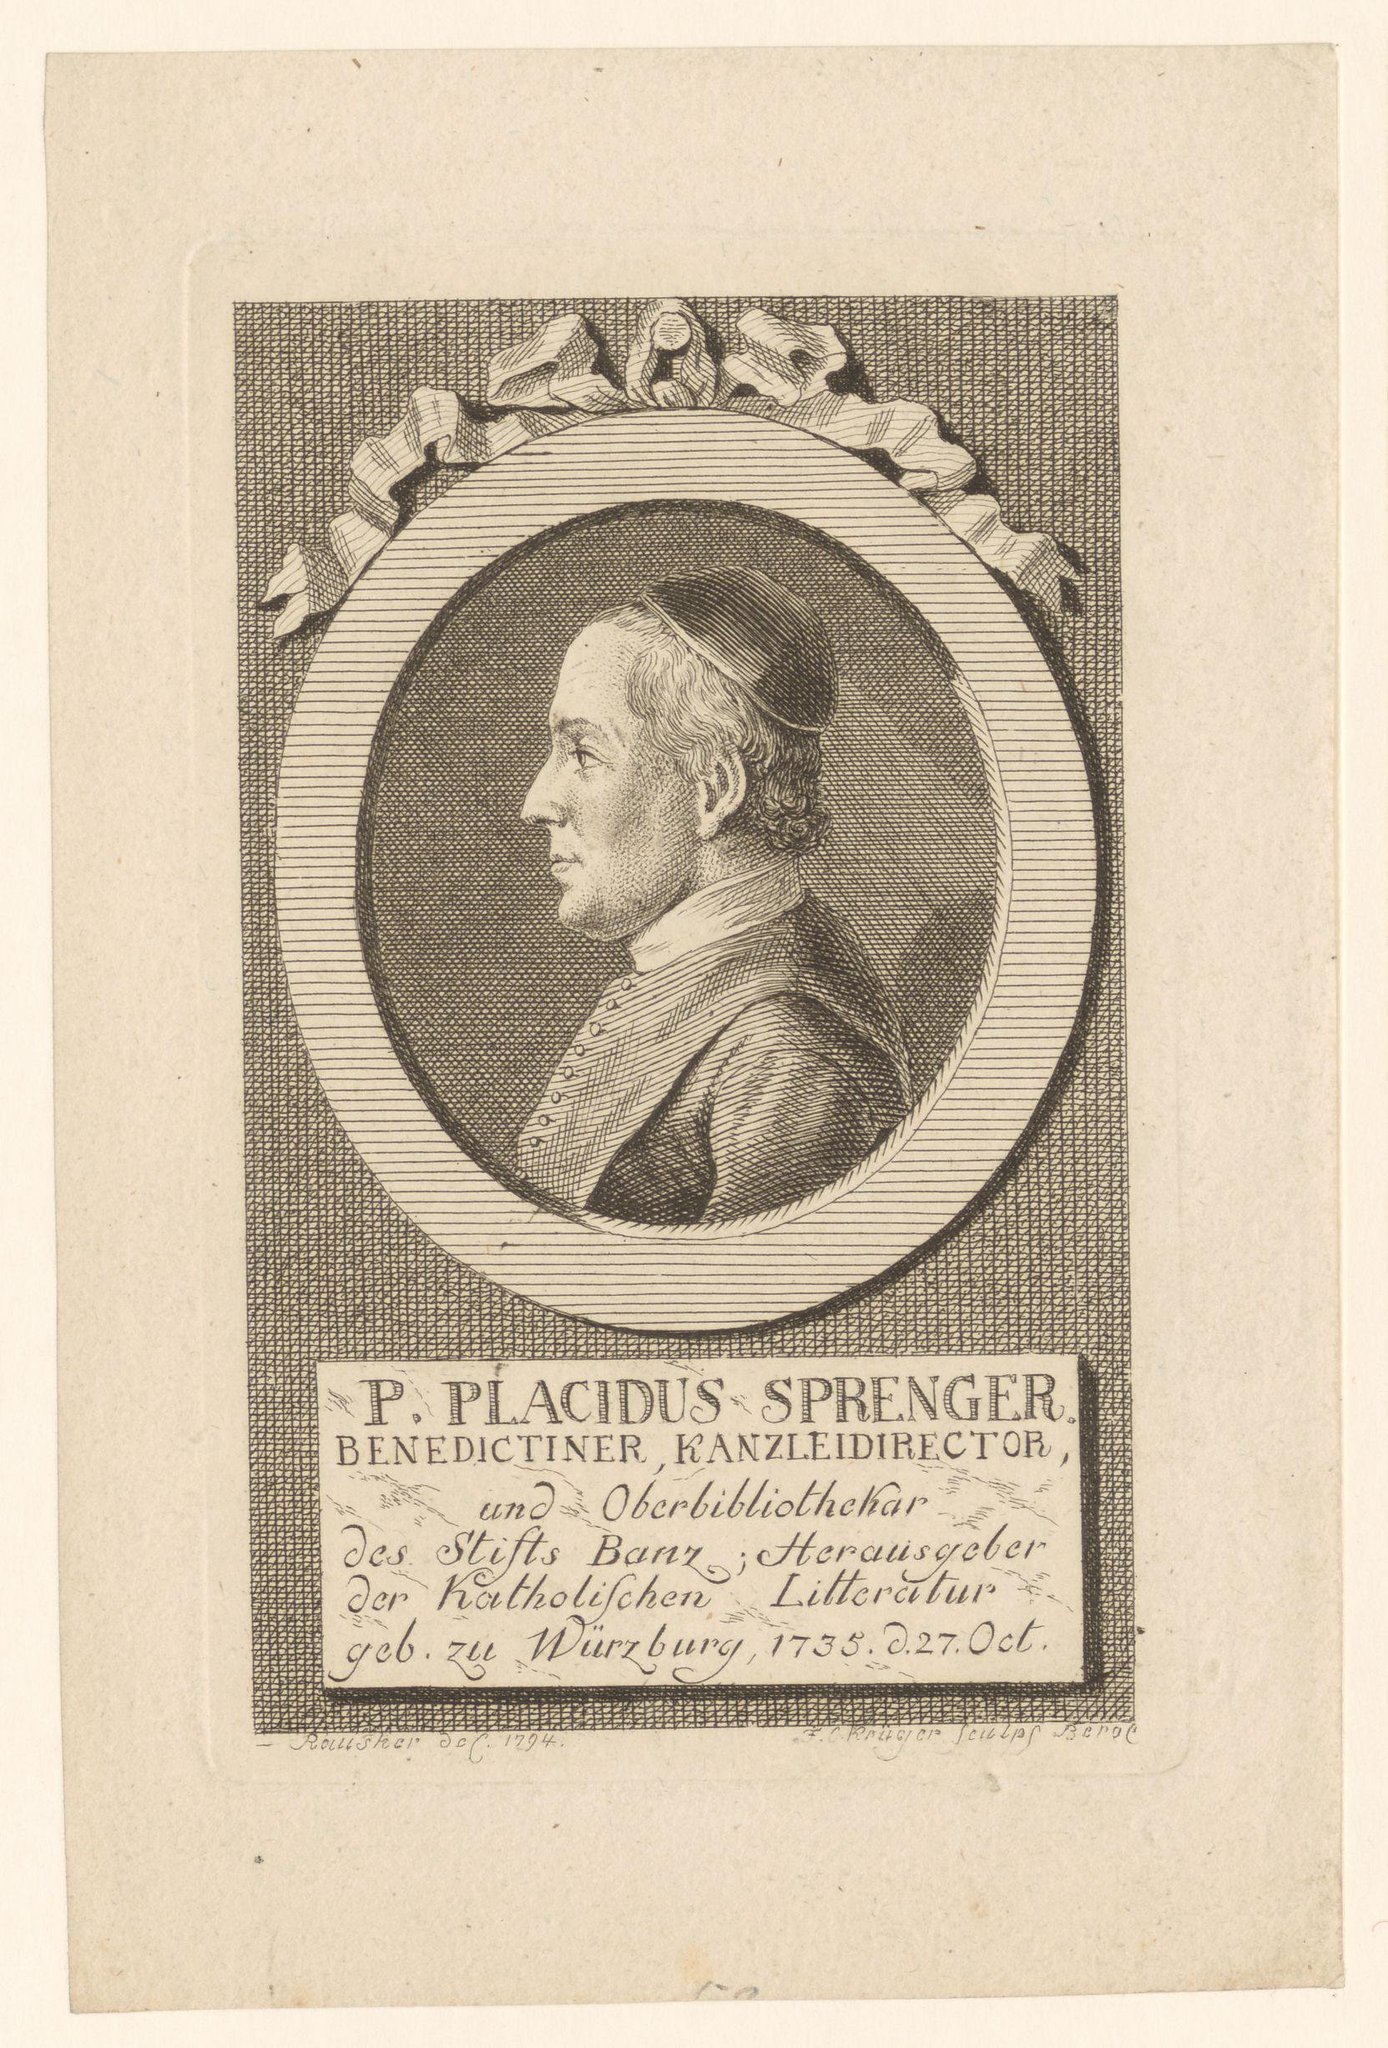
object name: print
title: Portret van Placidus Sprenger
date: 1774-1791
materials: paper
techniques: engraving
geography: berlin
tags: history and archaeology (+ portrait of scholar, scientist), theologian, historical persons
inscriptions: collector's mark: Lugt 2228